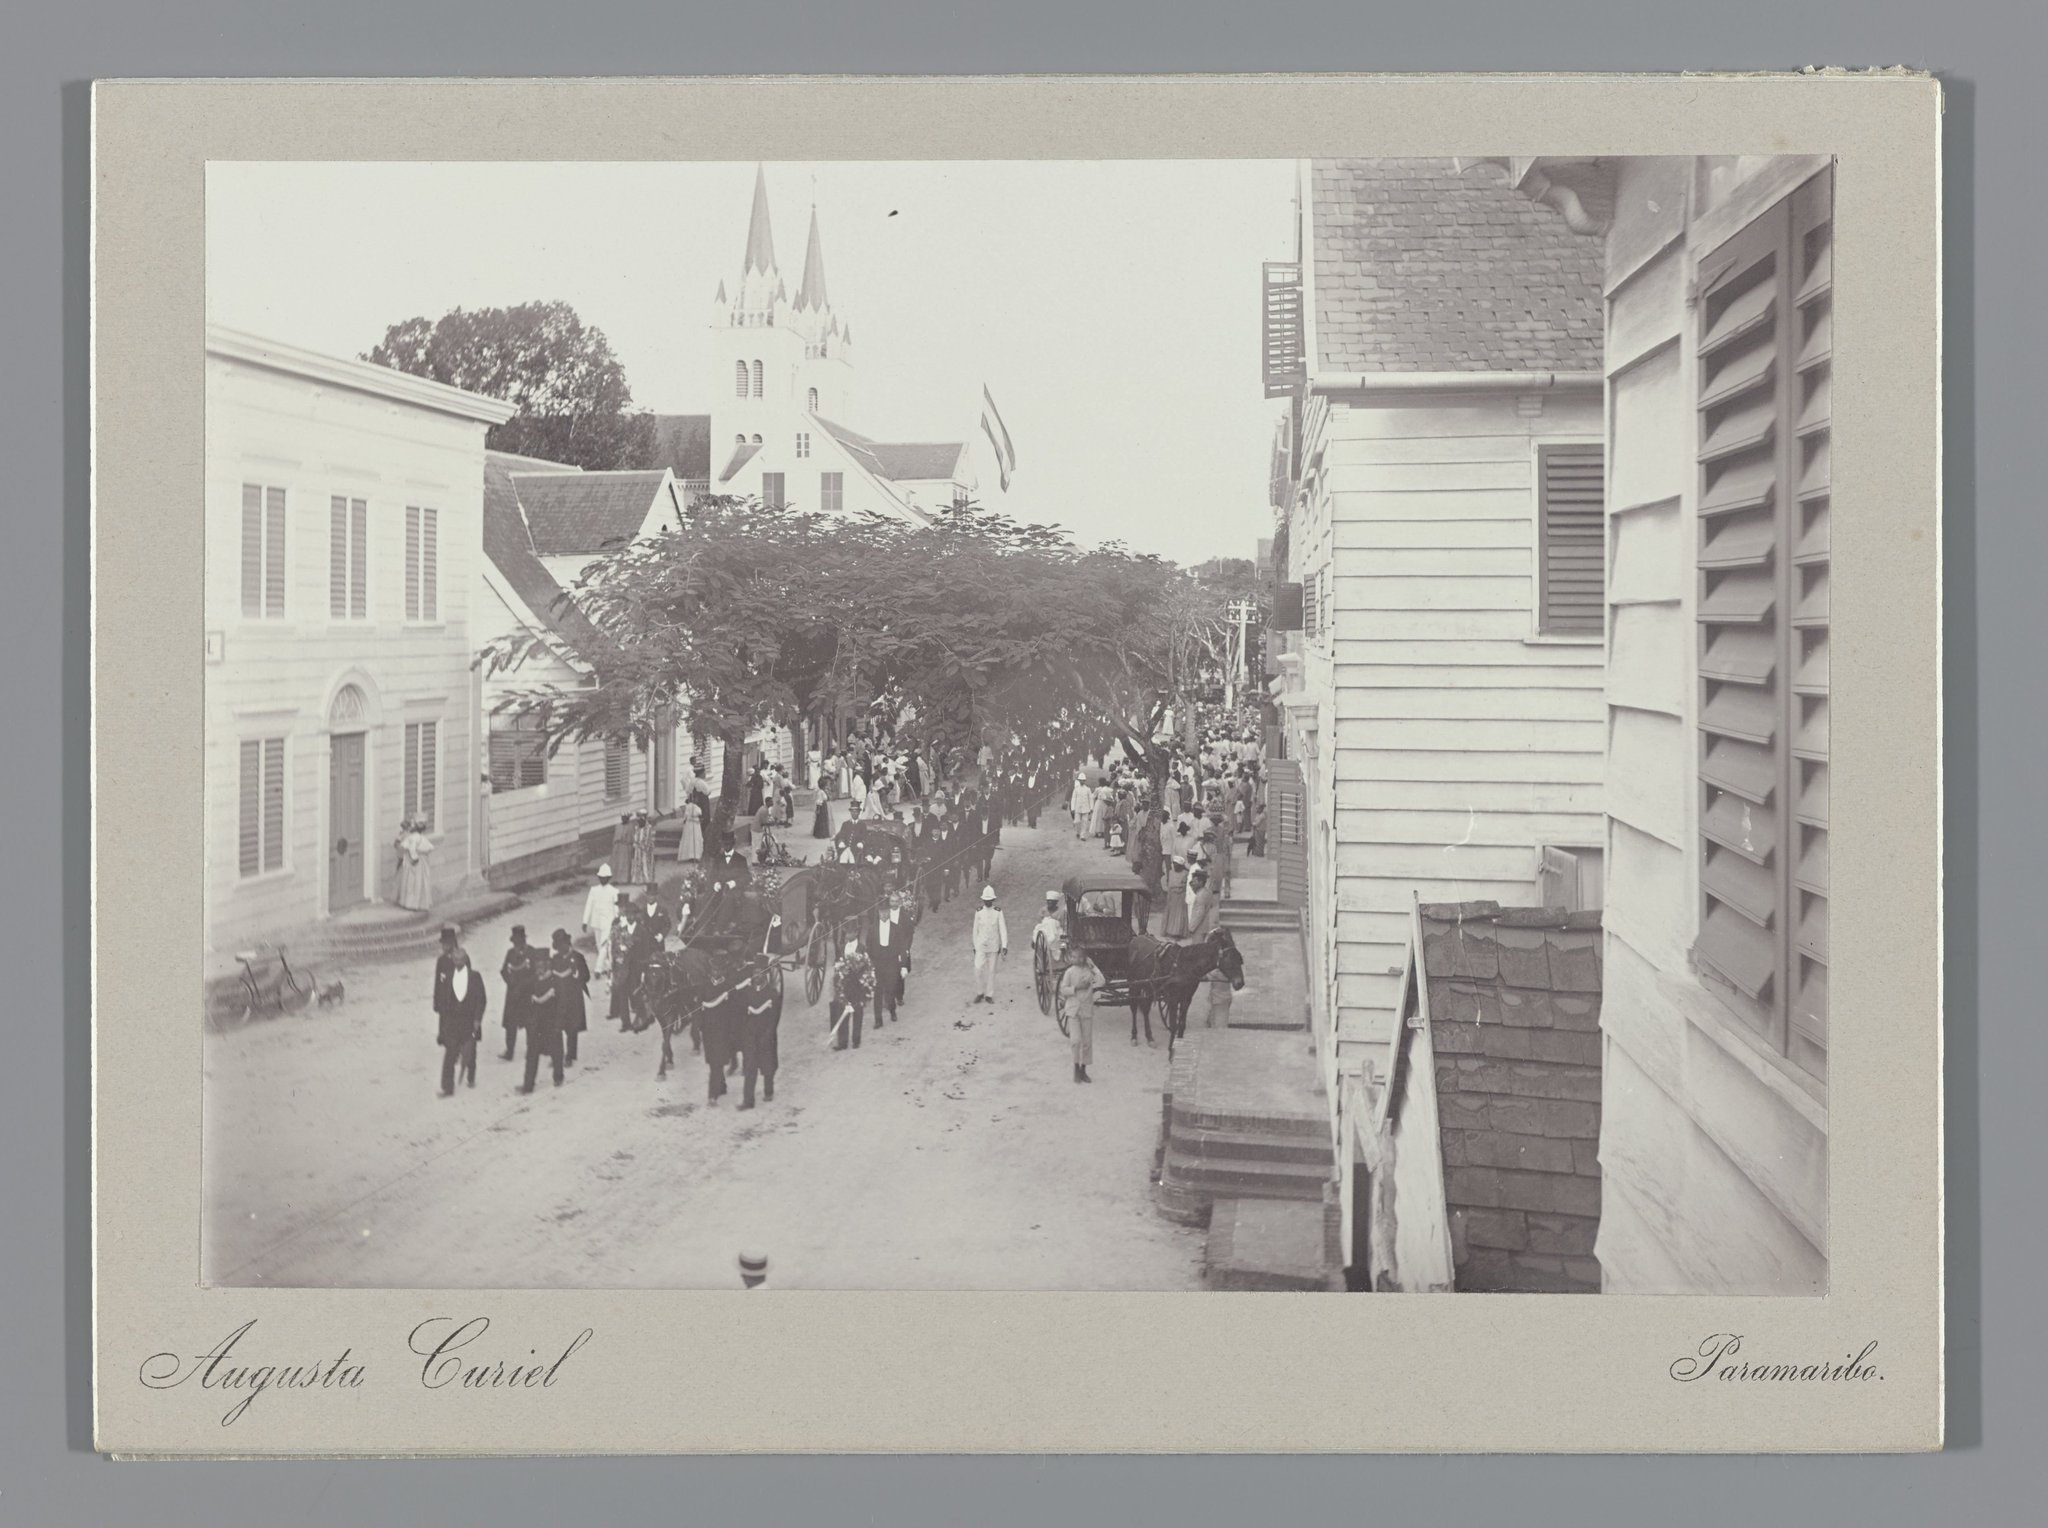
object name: photograph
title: Straatbeeld met begrafenisoptocht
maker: augusta curiel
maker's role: fotograaf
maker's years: 1873-1937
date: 1905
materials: paper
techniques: photography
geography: paramaribo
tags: paramaribo (stad)